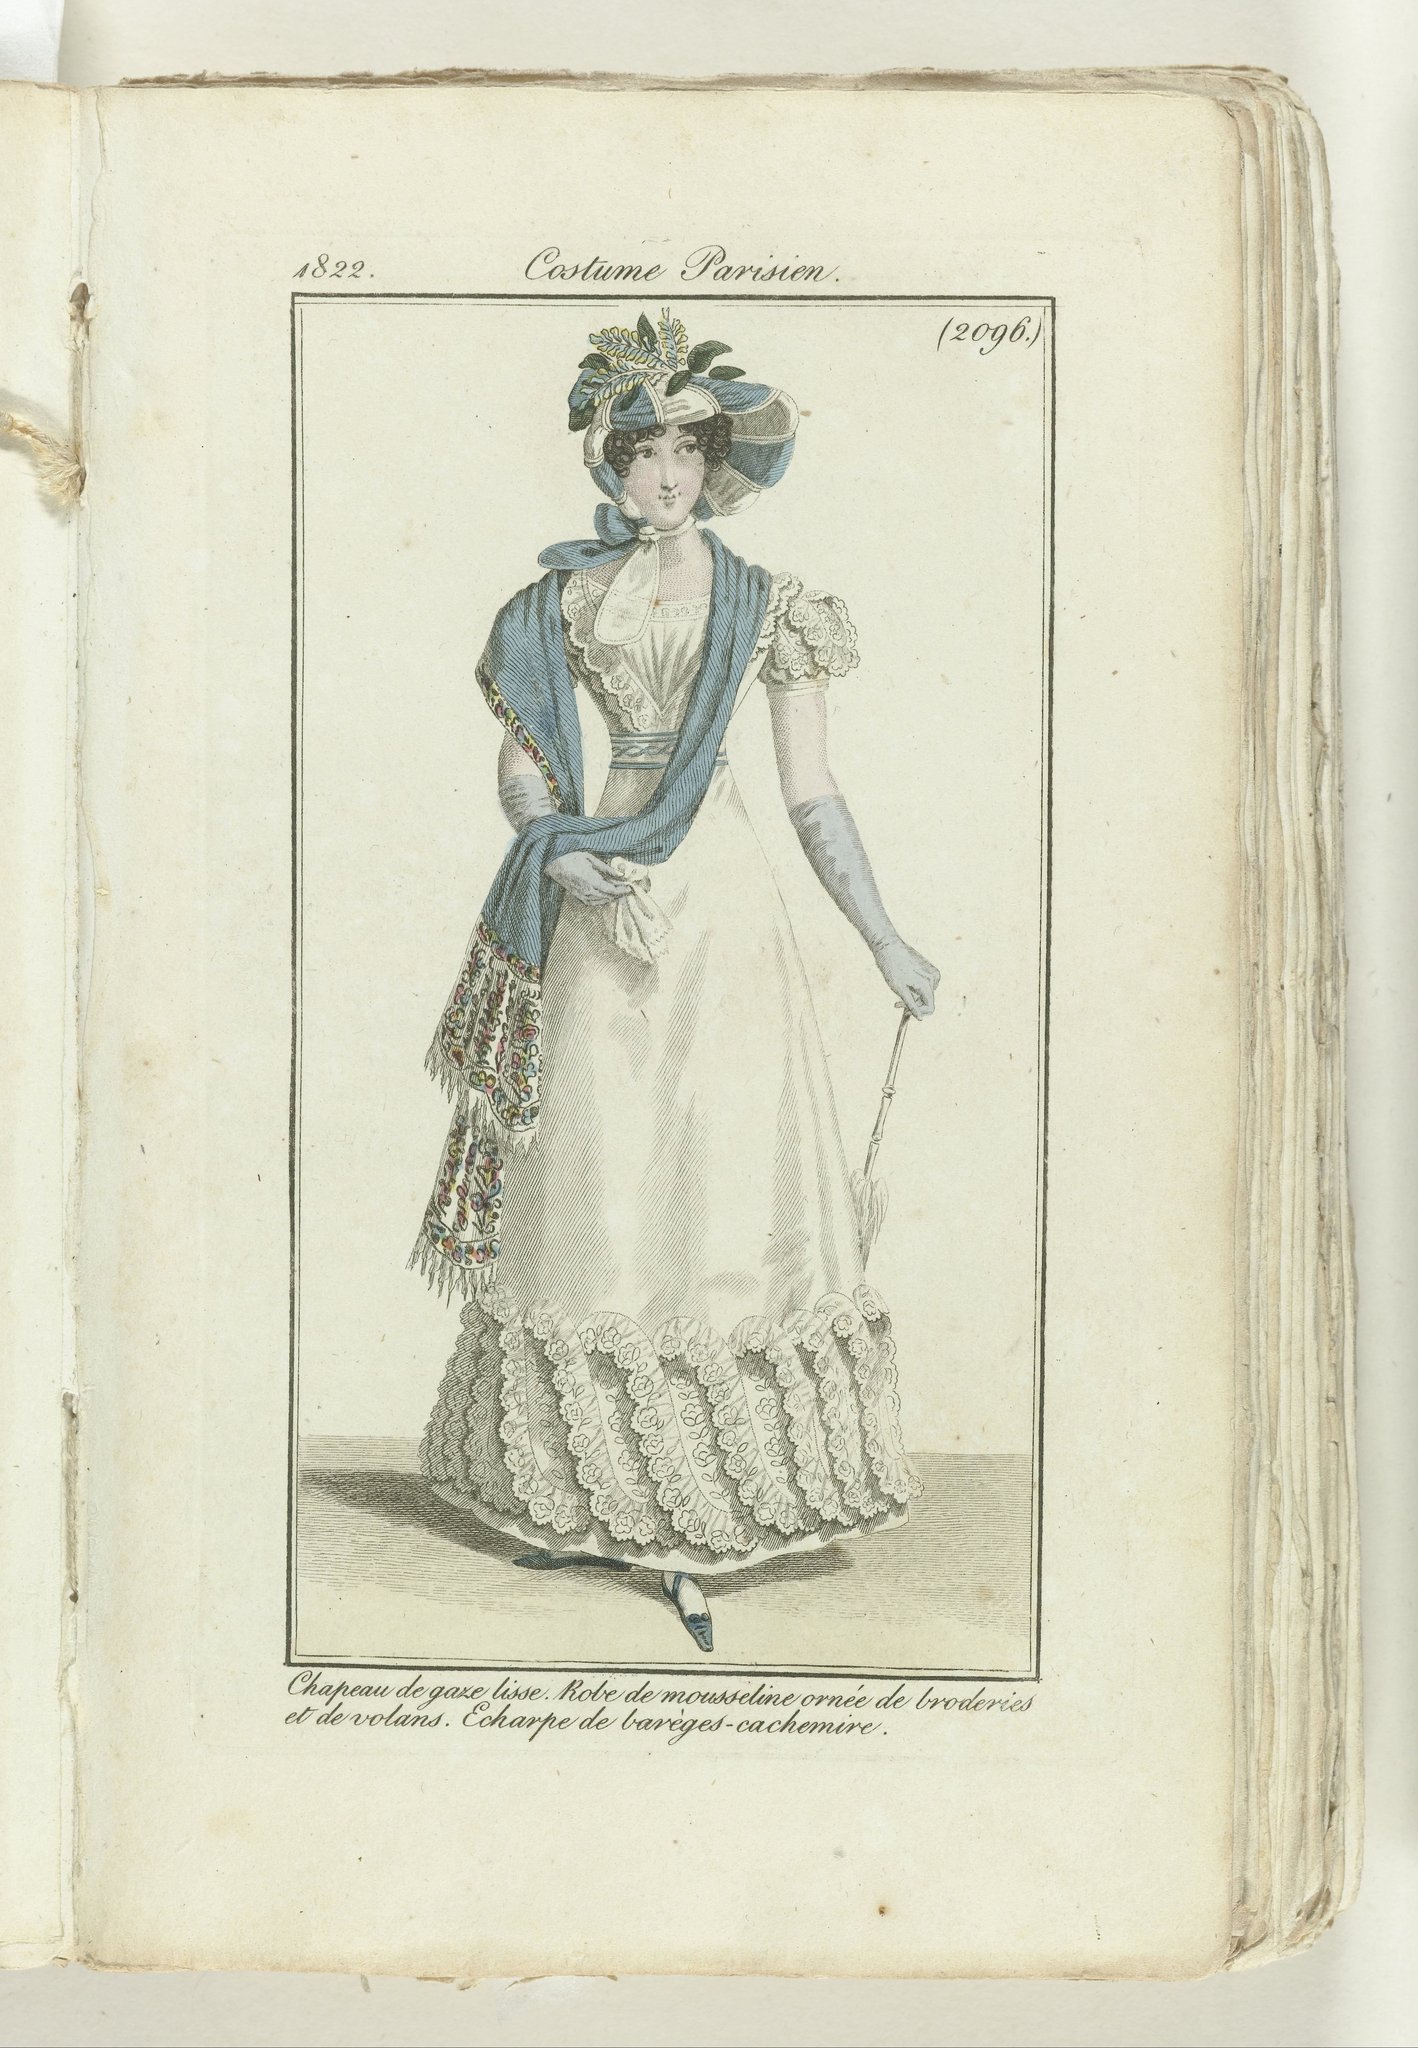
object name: fashion print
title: Journal des Dames et des Modes 1822, Costume Parisien (2096)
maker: Anonymous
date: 1822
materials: paper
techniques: etching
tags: head-gear, fashion plates, clothes, costume (+ women's clothes)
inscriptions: date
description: Prent uit het tijdschrift Journal des Dames et des Modes, 1822.